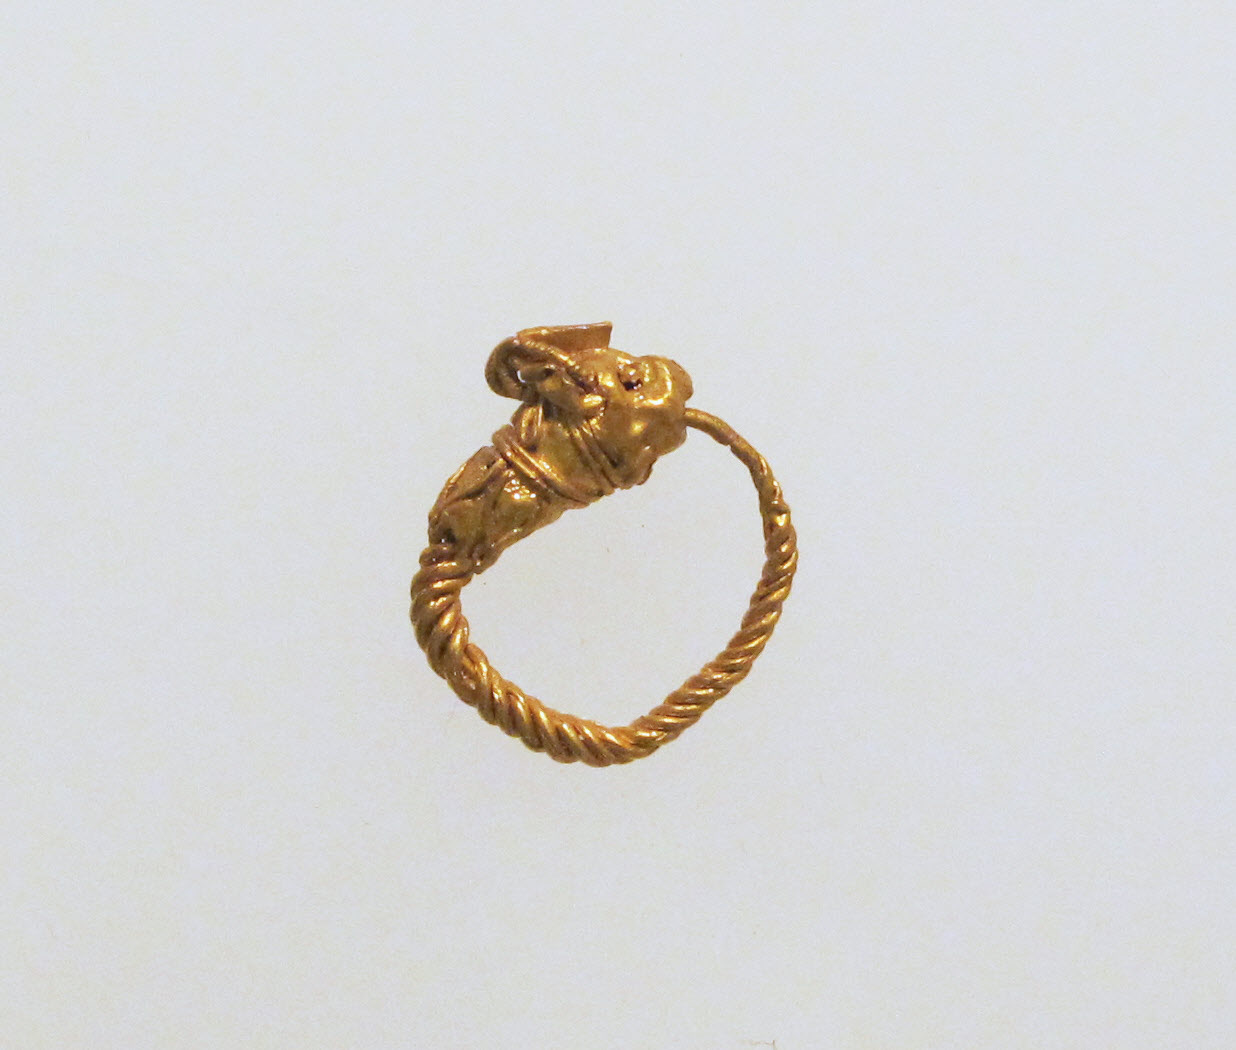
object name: earring with head of animal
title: Gold earring with head of an animal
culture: greek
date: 400-201 BCE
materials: gold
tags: animals